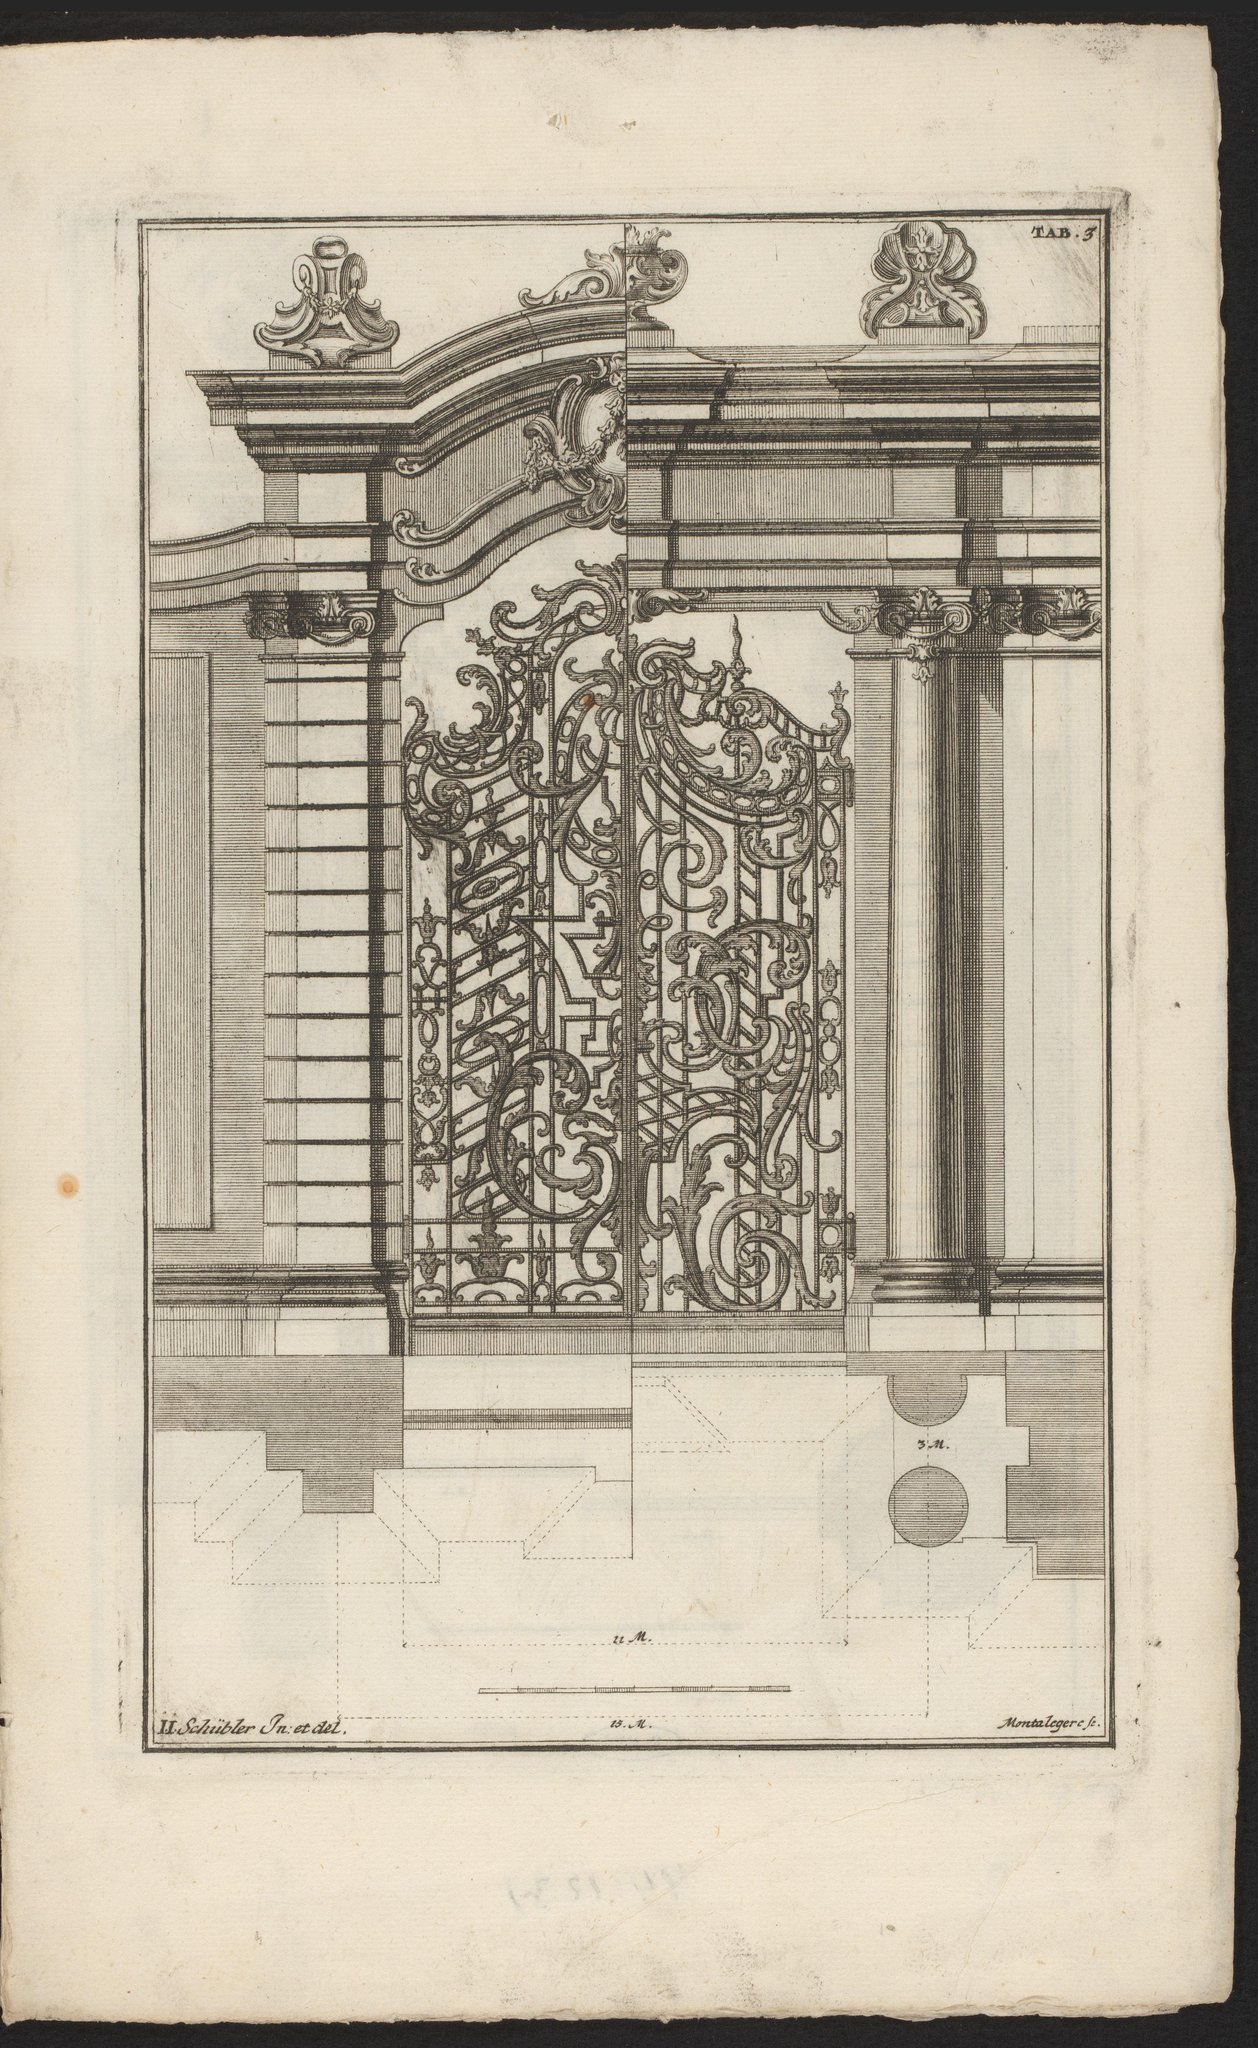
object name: ornament print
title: Tuinportaal met hekwerk, cartouche en vaas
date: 1699-1726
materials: paper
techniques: engraving, etching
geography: nuremberg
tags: vase ~ ornament, fence, wall, paling, ornament ~ cartouche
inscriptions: collector's mark: Lugt 2228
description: Prent uit: Schübler, Johann Jakob. Weitere Eröffnung zur Gründlichen Säulen Ordnung von neu inventirten Garten Portalen (...). [Neurenberg]: Weigel, Johann Christoph, [voor 1726].